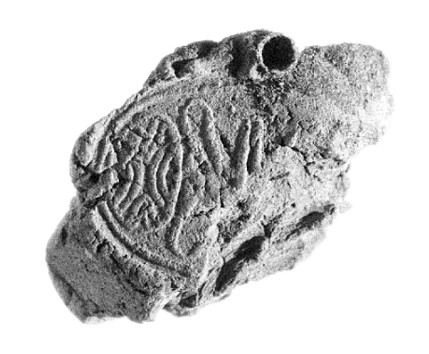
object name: sealing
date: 1981-1640 BCE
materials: mud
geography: egypt